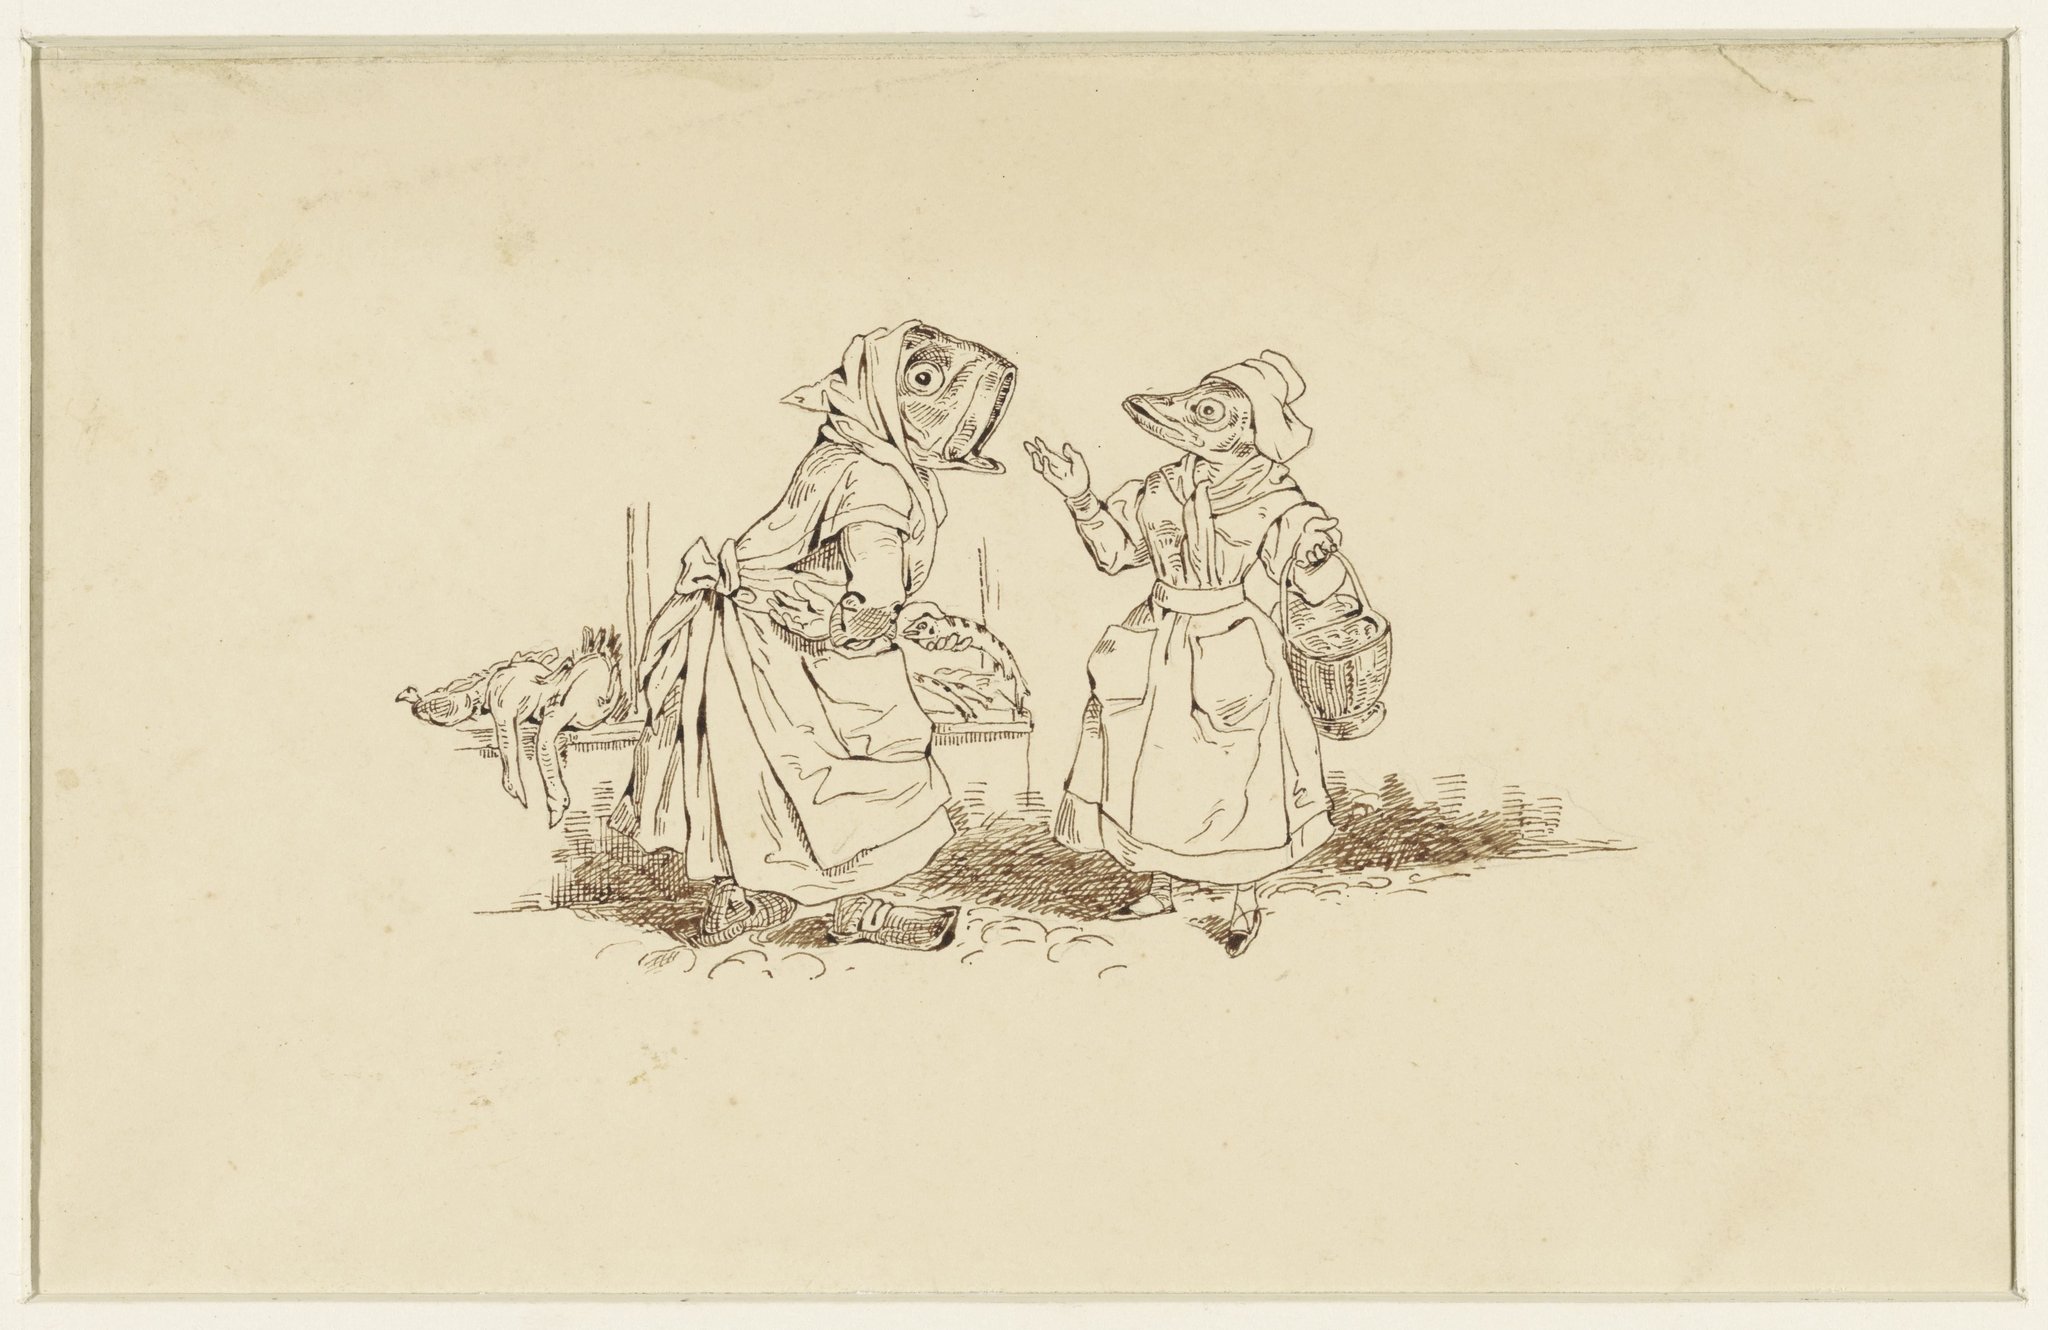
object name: drawing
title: Marktscène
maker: wilhelm koller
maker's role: draughtsman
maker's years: 1829-1884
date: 1839-1884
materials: ink, paper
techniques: pen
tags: animals acting as human beings, stall, booth (~ market)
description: Marktscène: een kabeljauw als marktvrouw verkleed, een haring in de linkerhand, in discussie met een als vrouw verklede schelvis.